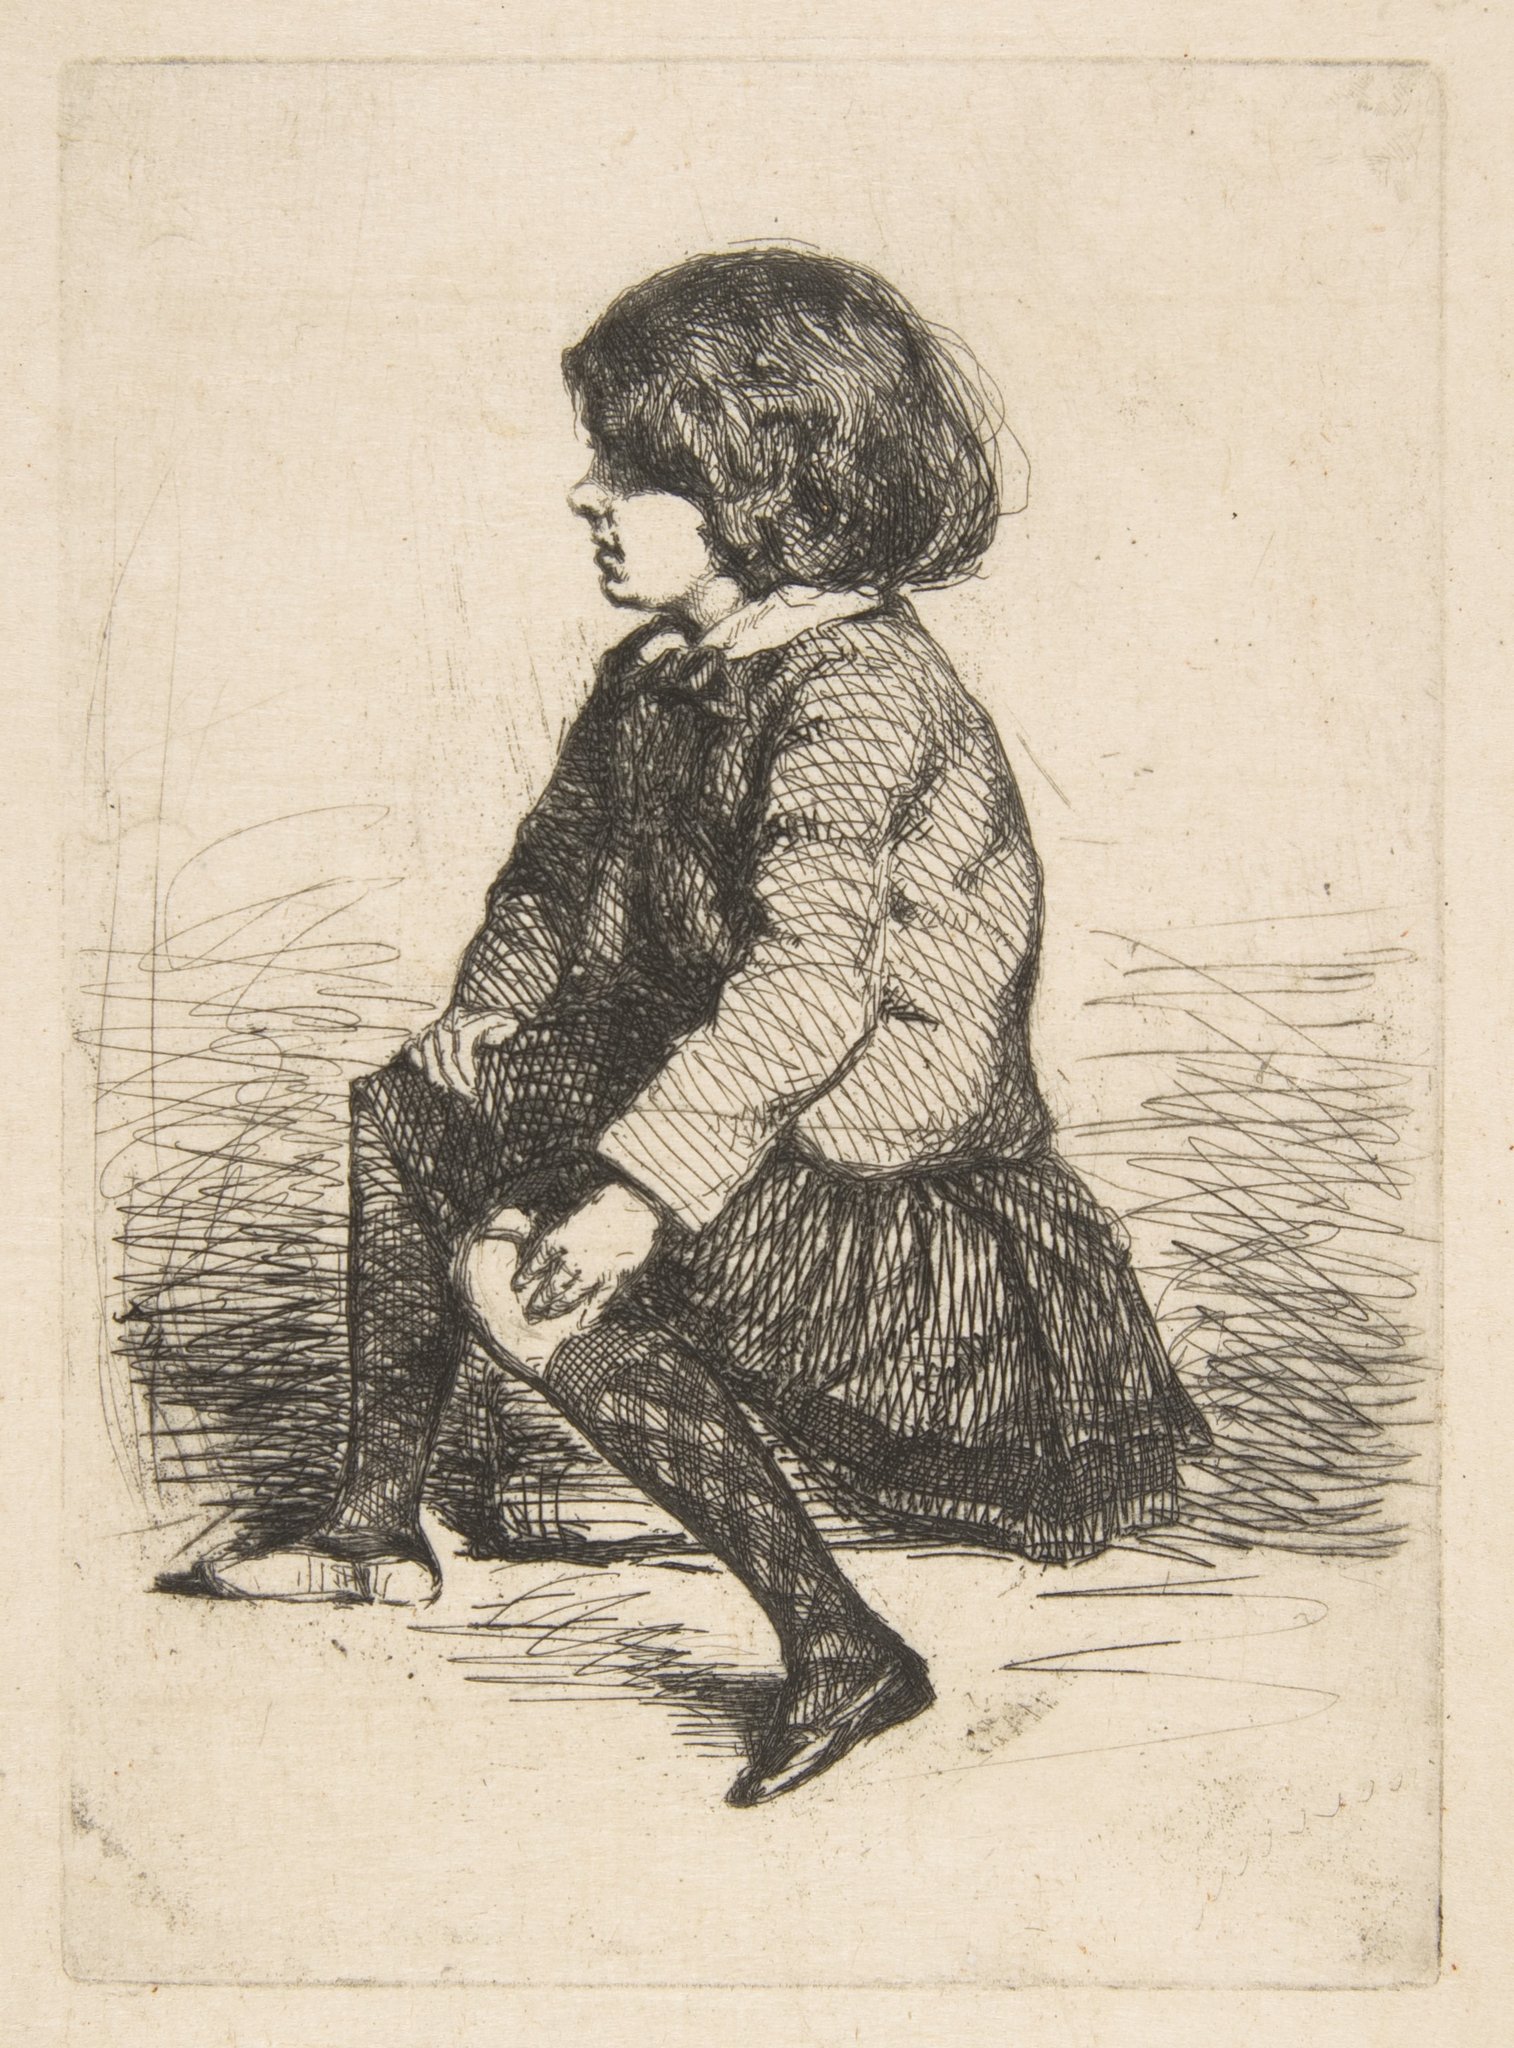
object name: print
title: Seymour Seated (Seymour Haden, Jr., Seated)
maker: james mcneill whistler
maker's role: artist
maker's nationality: american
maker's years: 1834-1903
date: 1857-1858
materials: ink, paper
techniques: etching, printing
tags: boys